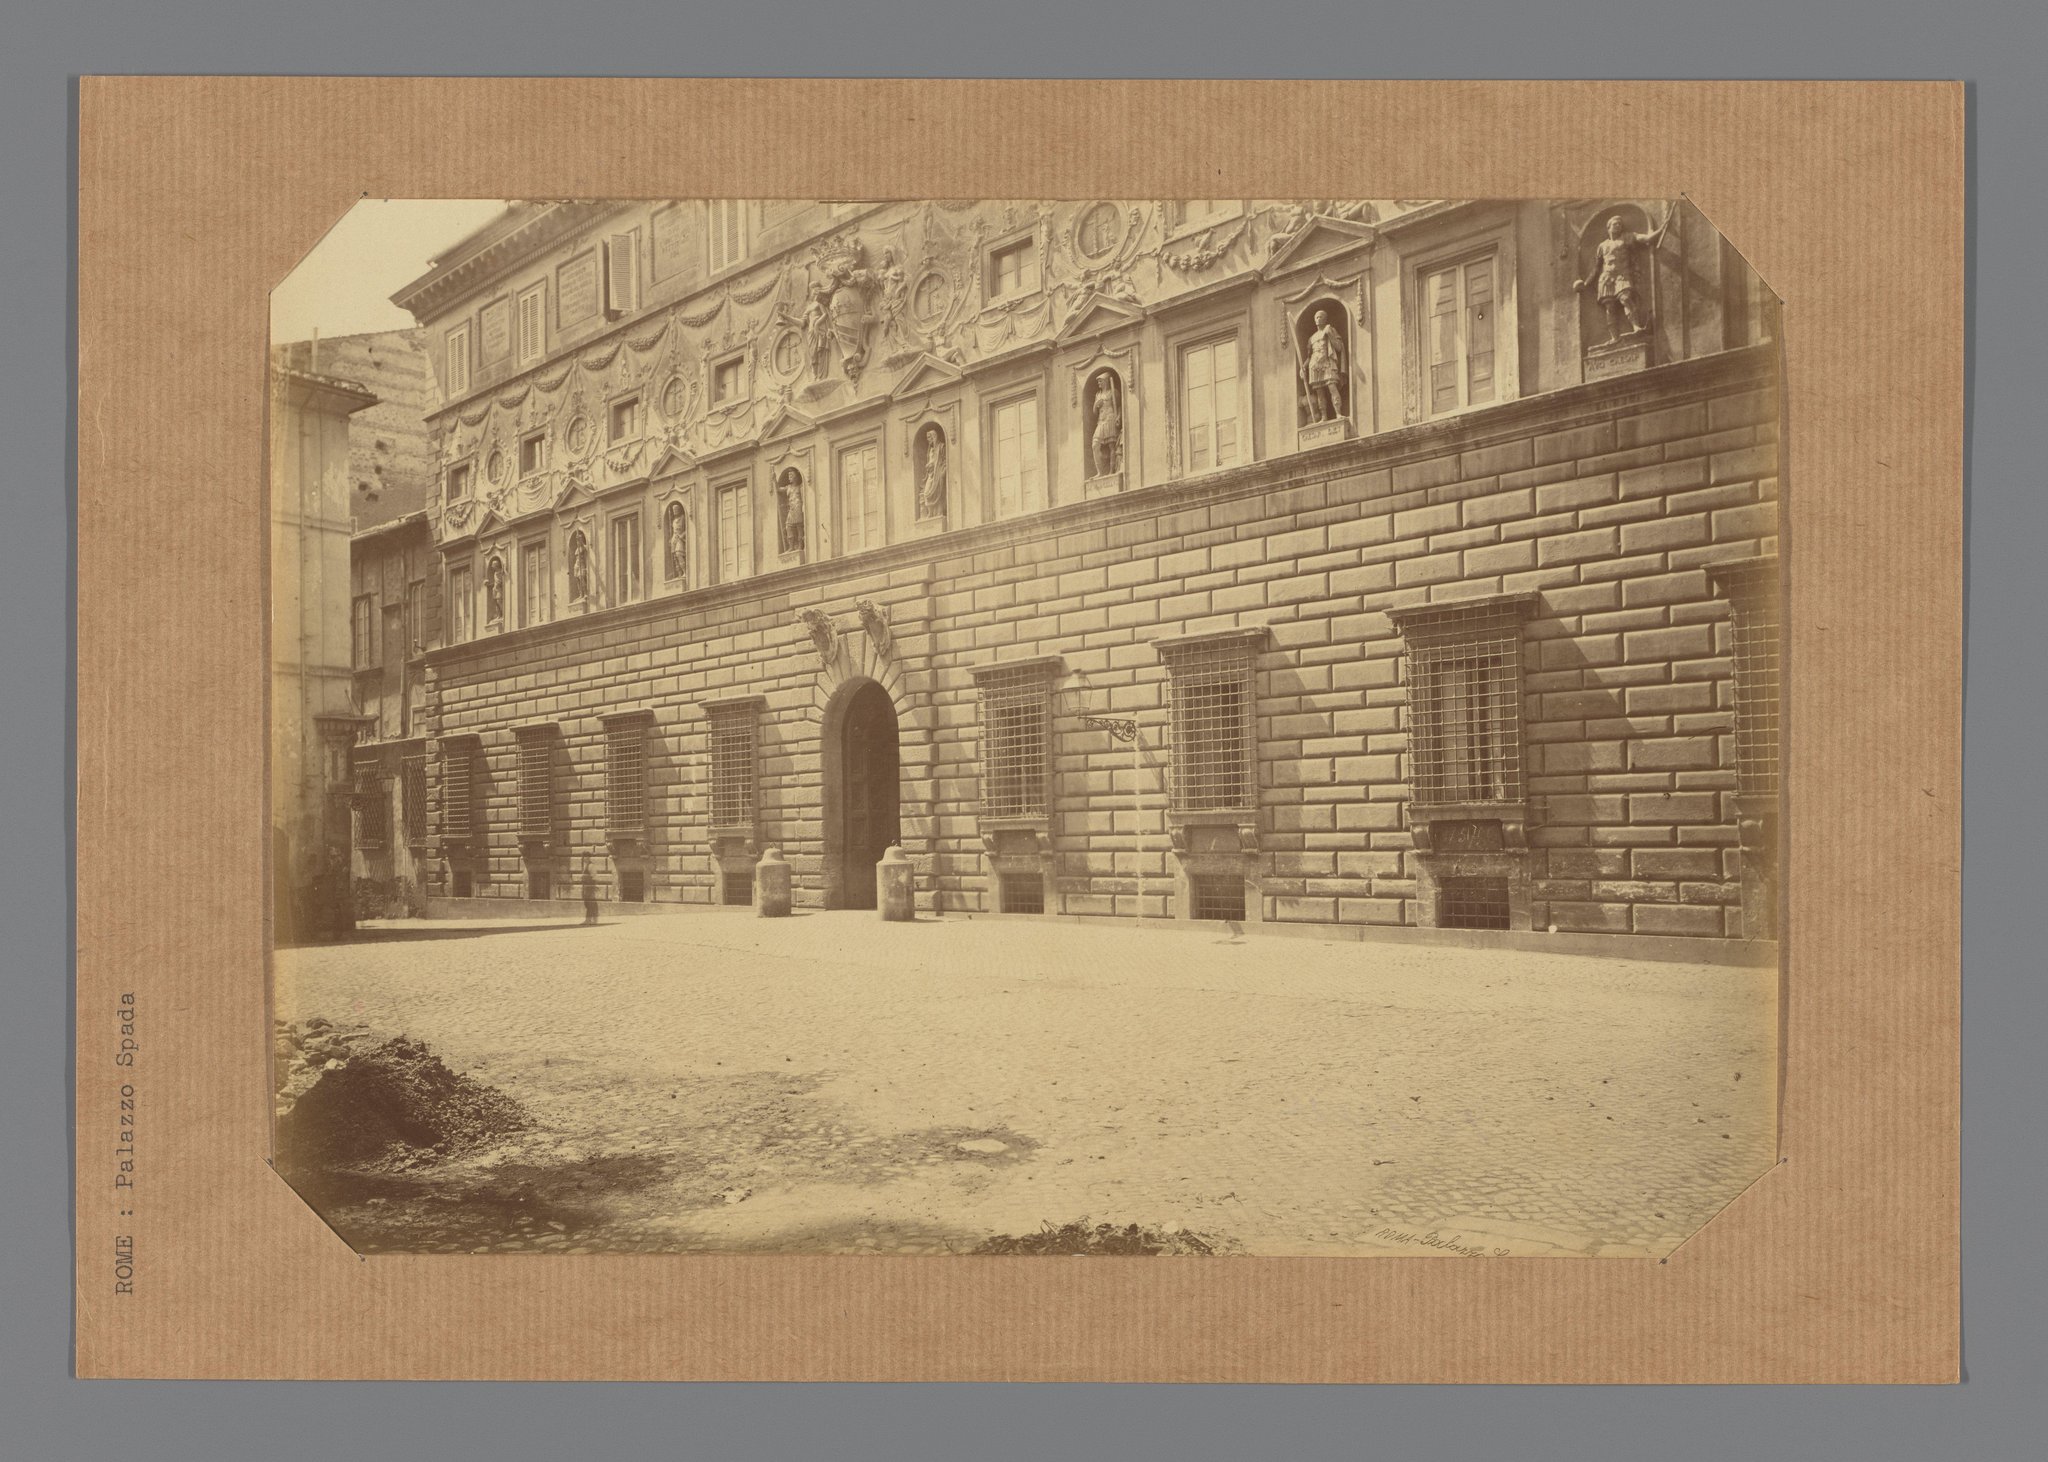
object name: photograph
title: Rome: Palazzo Spada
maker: Anonymous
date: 1850-1899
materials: paper, photographic support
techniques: albumen print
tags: palazzo spada